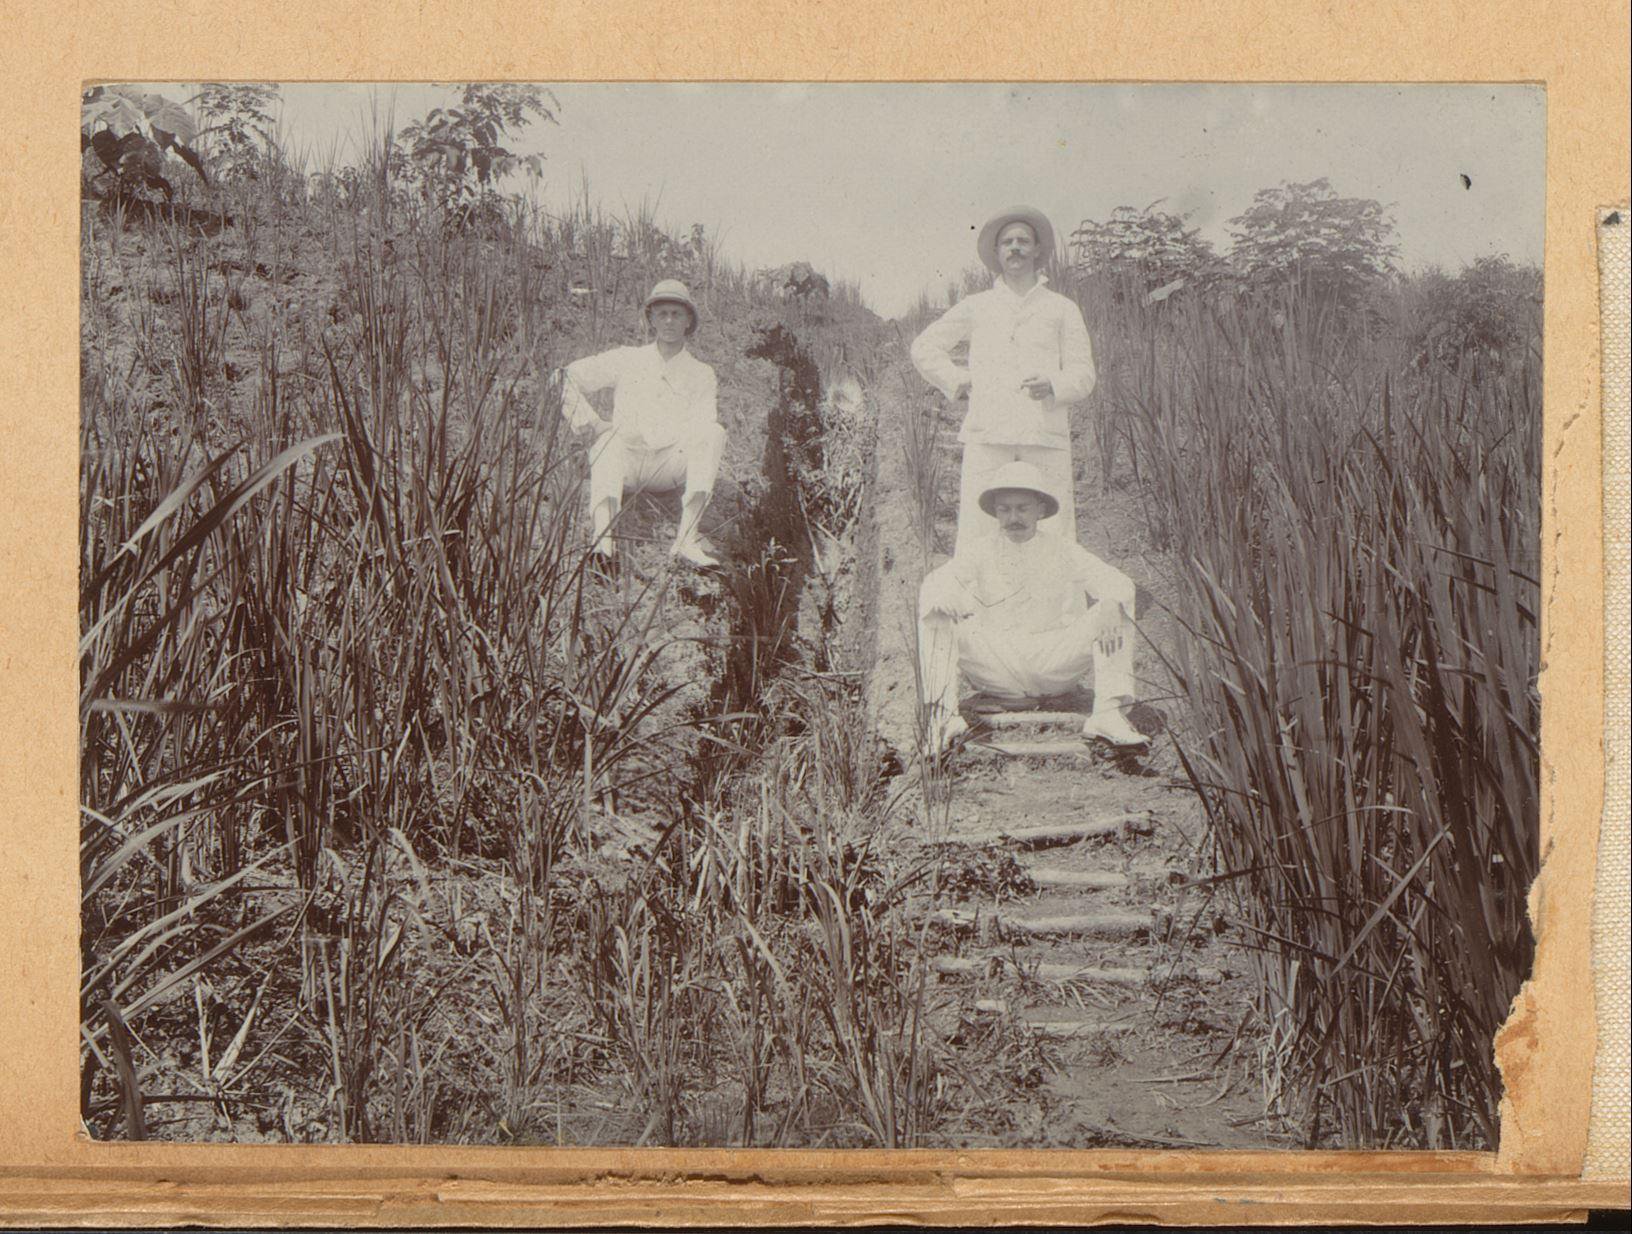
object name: photograph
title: Drie Europese mannen in tropenkleding zittend op een aarden trap in Nederlands-Indië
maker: Anonymous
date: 1900-1920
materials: photographic support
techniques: gelatin silver print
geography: dutch east indies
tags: adult man, dutch east indies, the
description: Onderdeel van Familiealbum met foto's van een familie in de voormalige kolonie Nederlands-Indië en van een suikerfabriek in Purworejo.